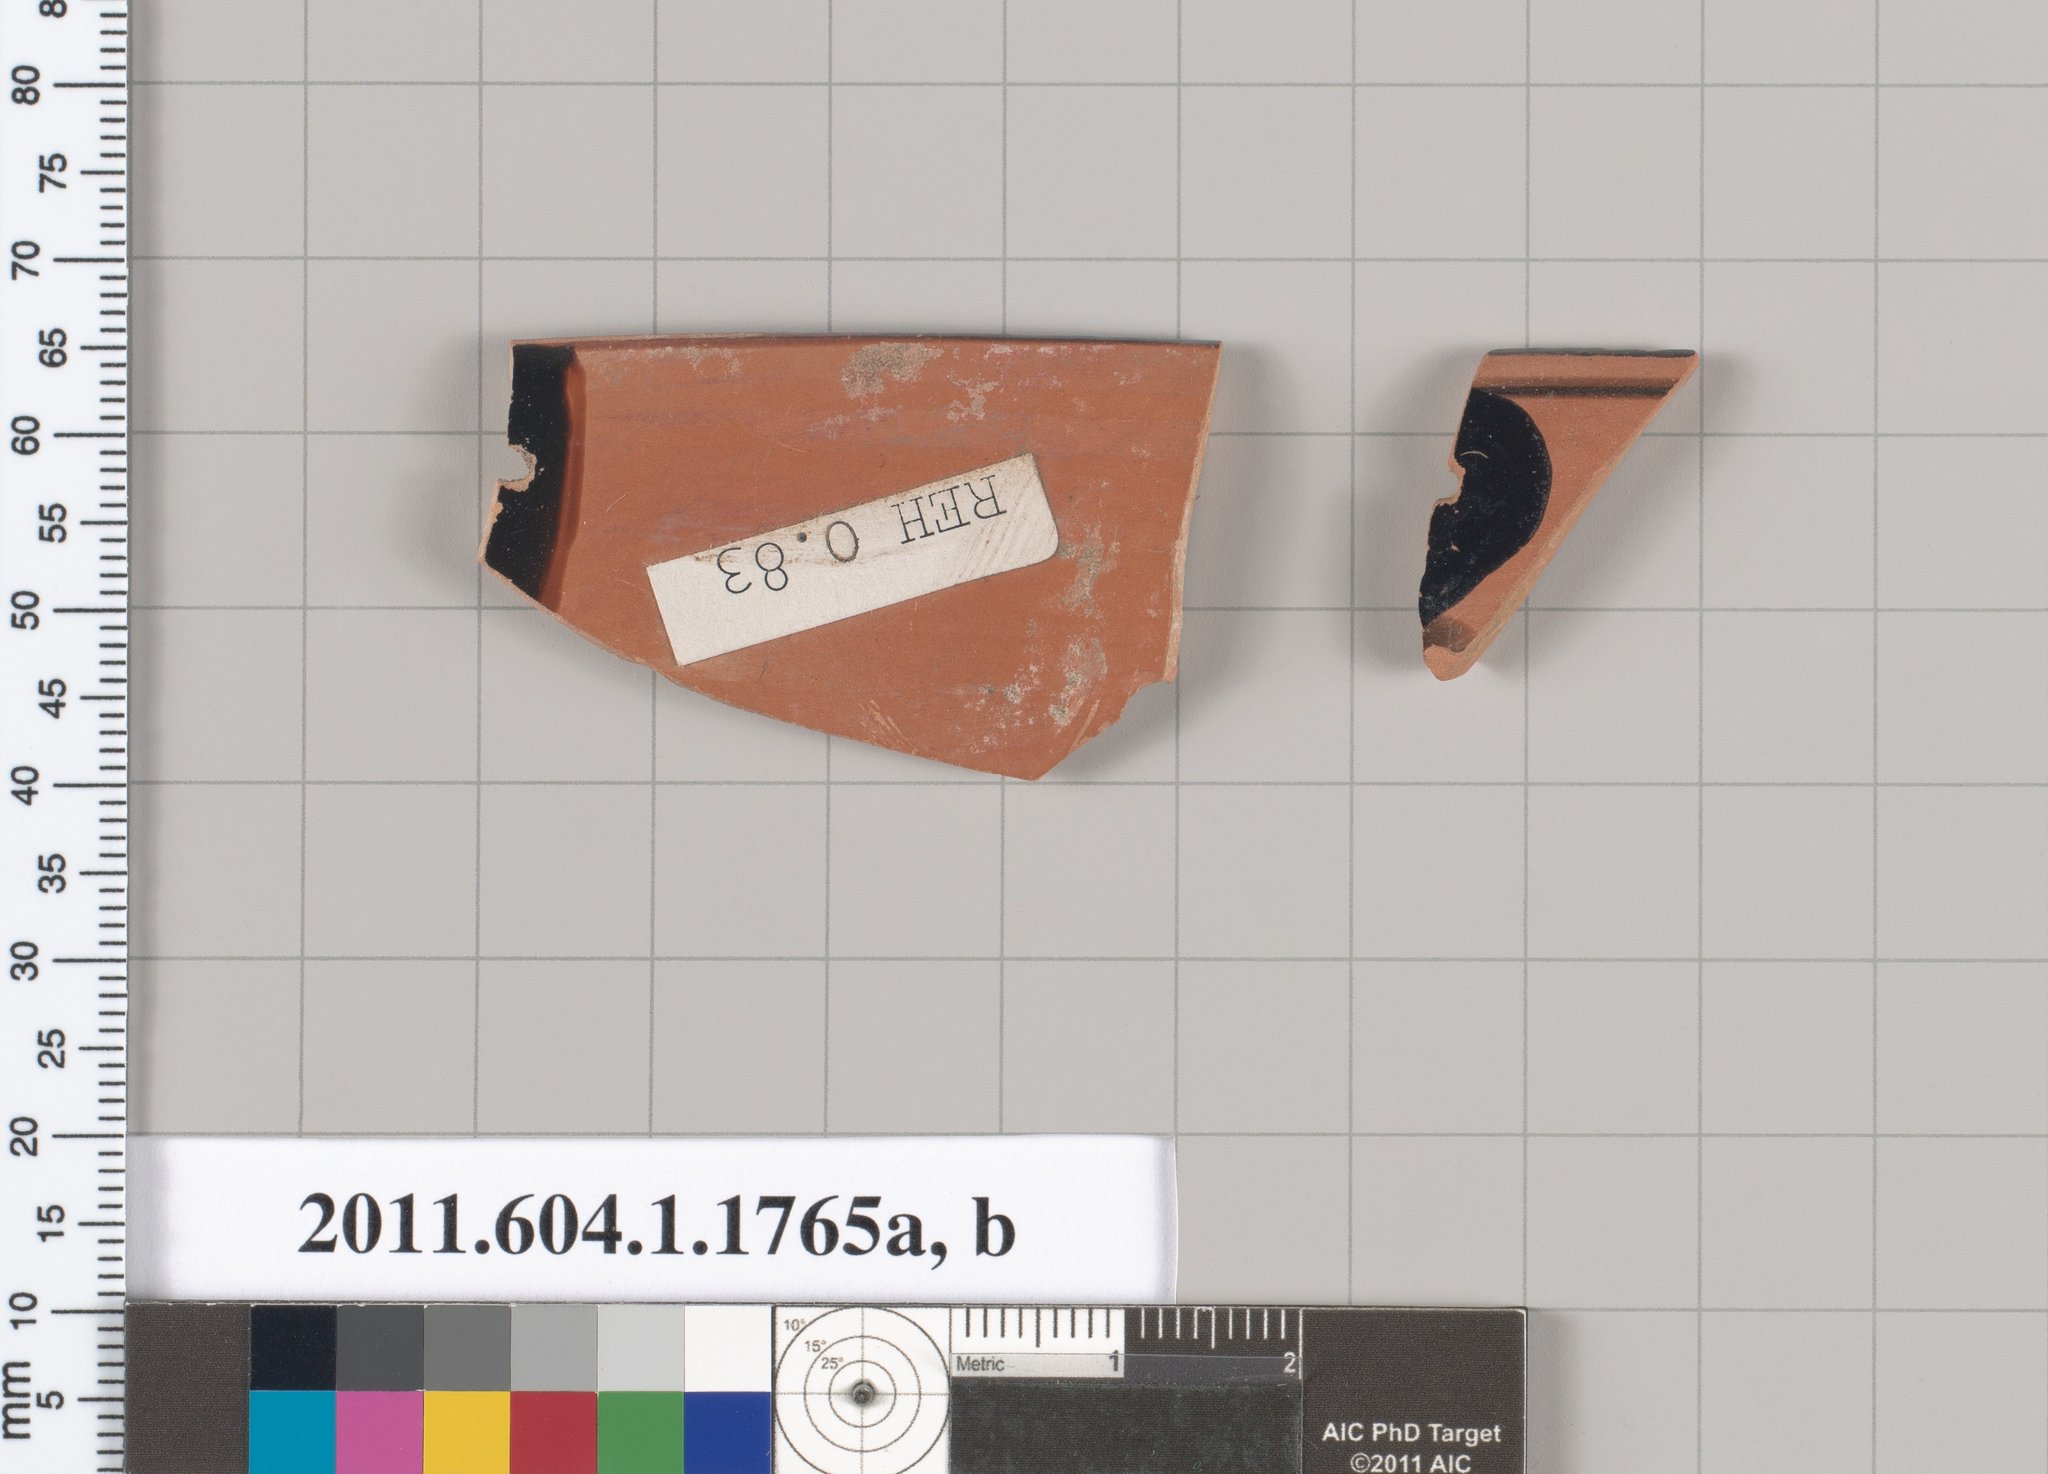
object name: kylix fragment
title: Terracotta rim fragments of kylikes(drinking cups)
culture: greek, attic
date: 500-401 BCE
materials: terracotta